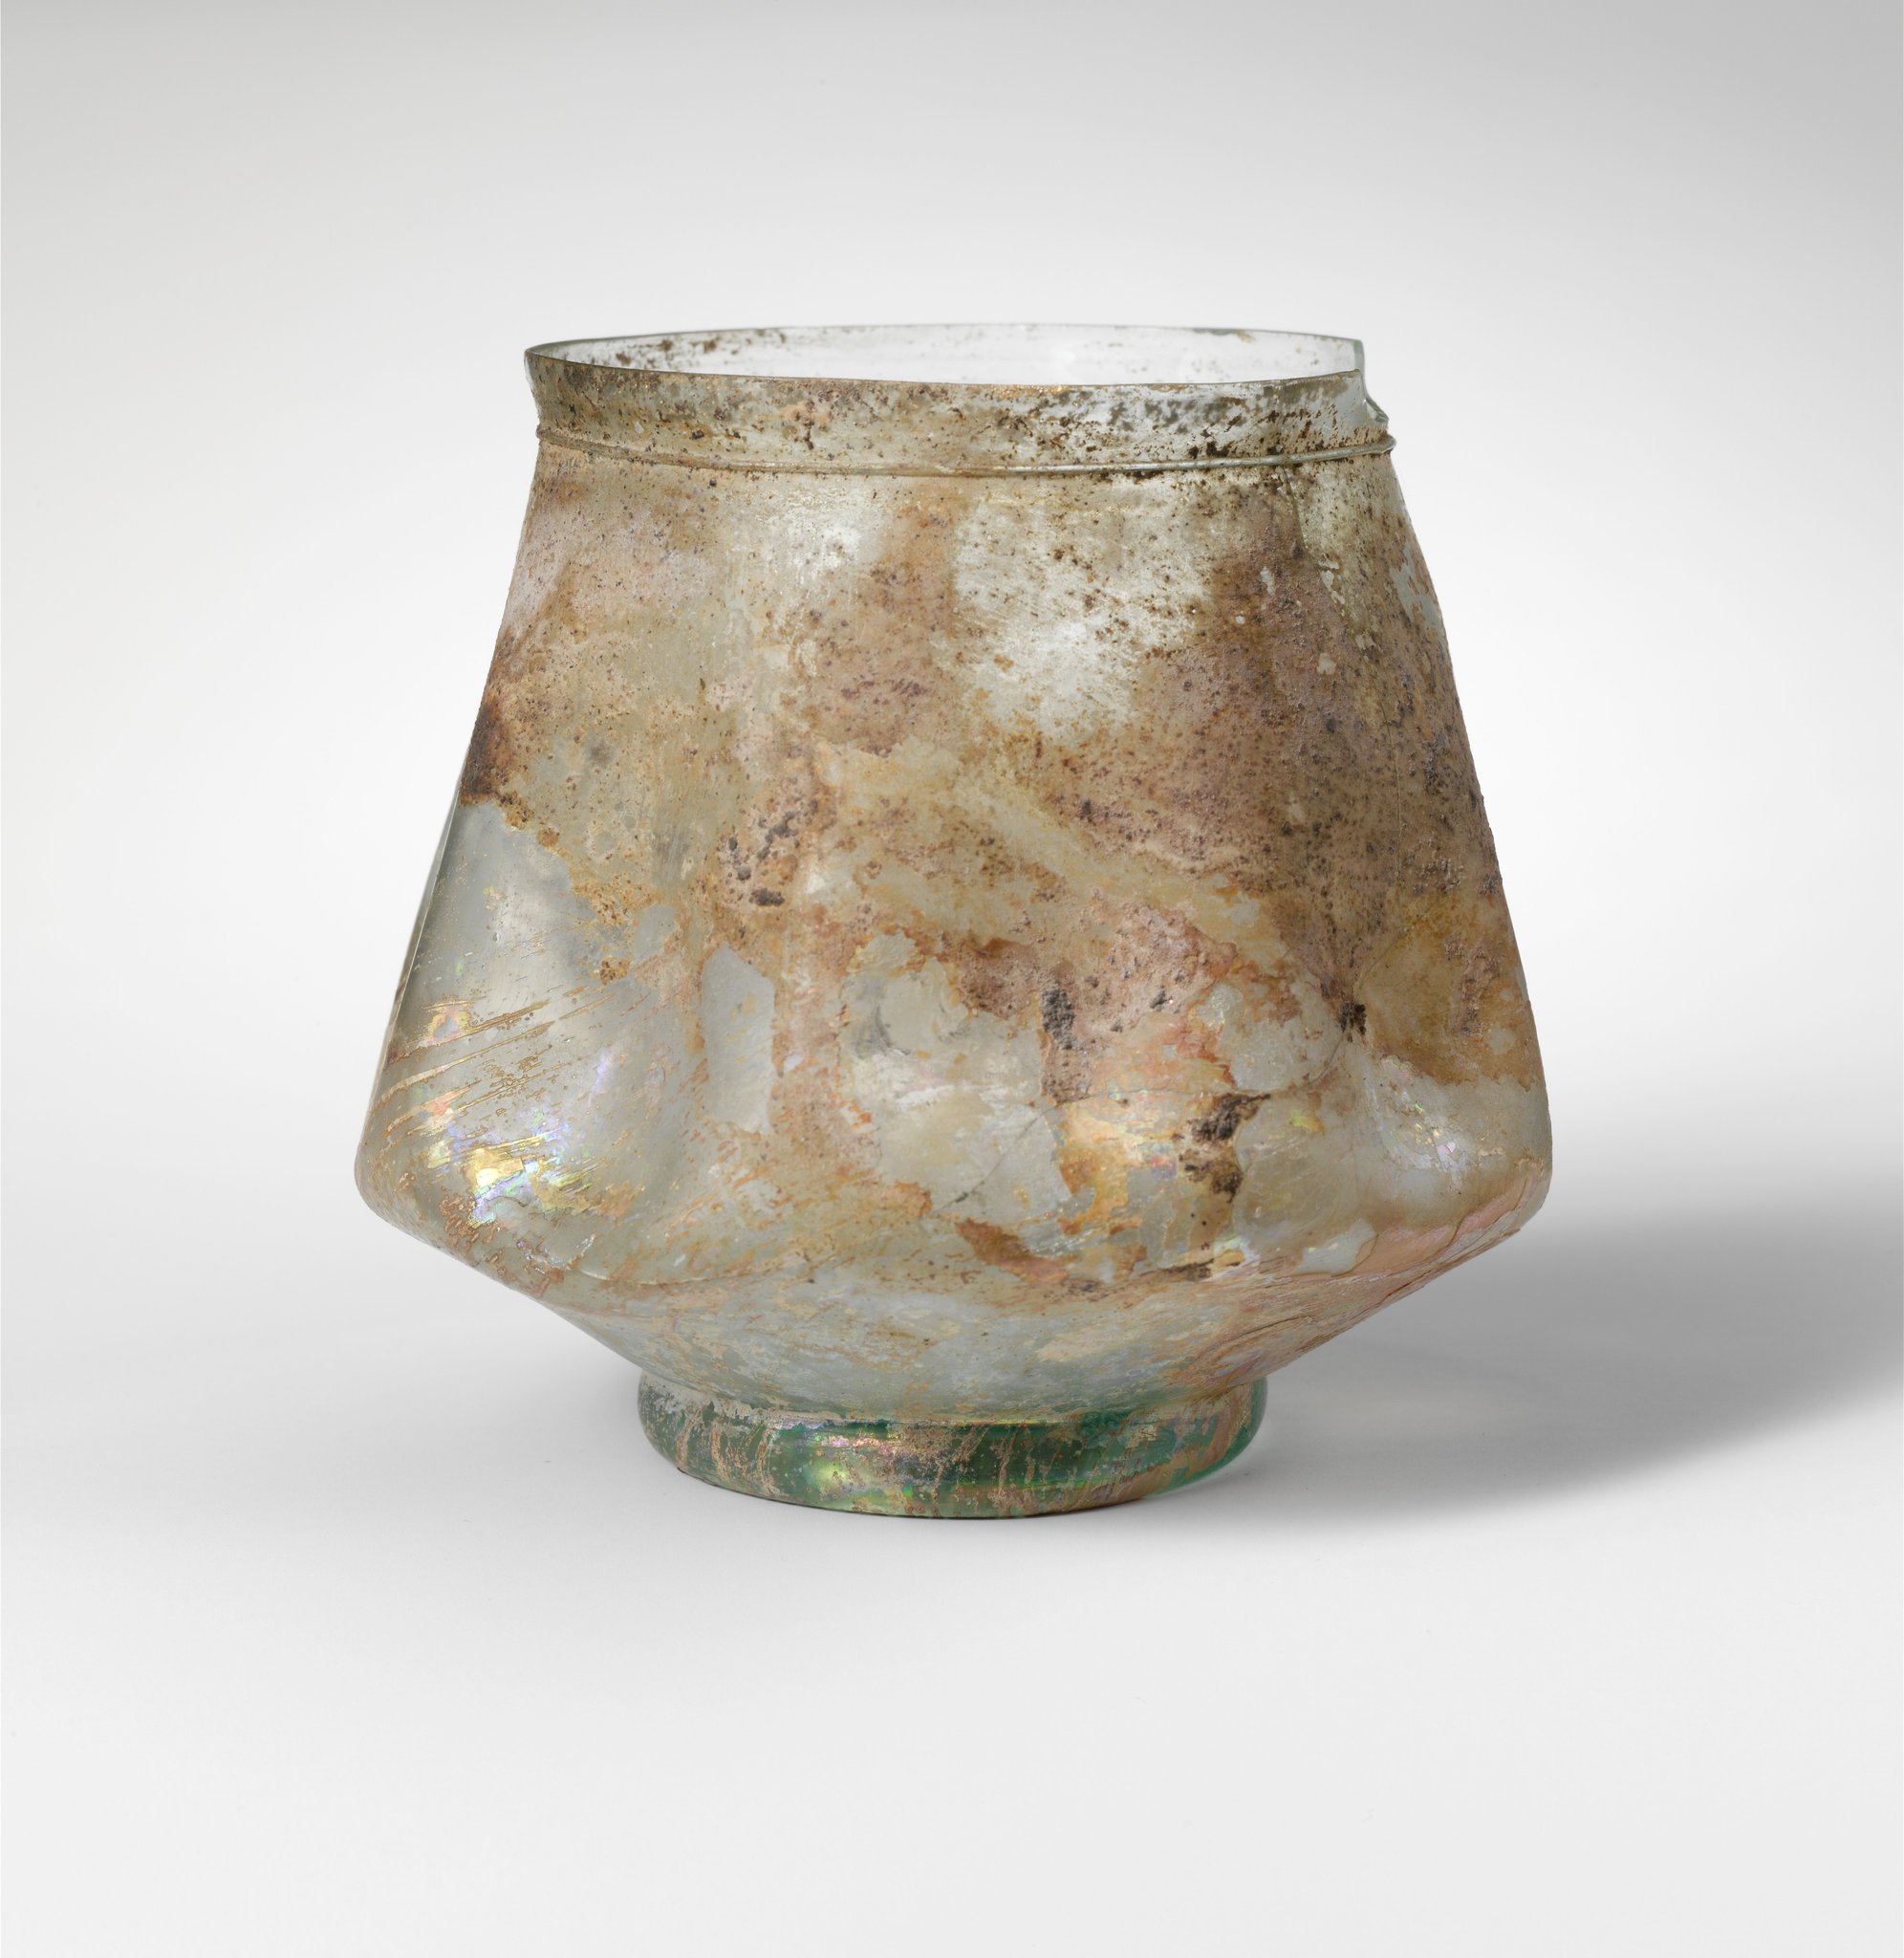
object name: cup, indented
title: Glass cup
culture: roman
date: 101-300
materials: glass